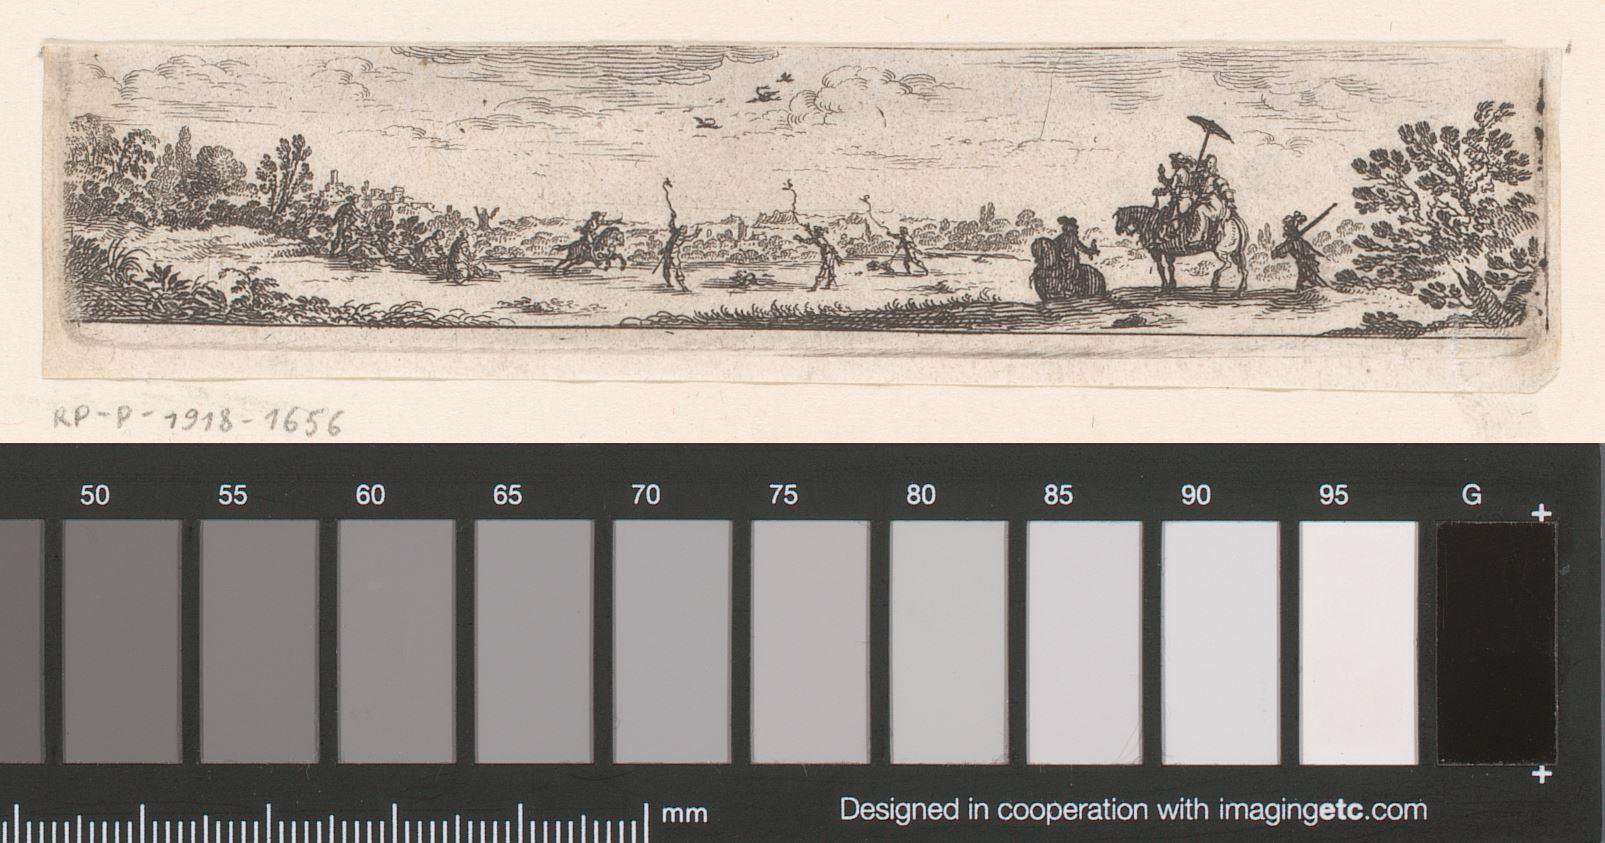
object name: print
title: Vignetten met buitentaferelen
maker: nicolas cochin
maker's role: print maker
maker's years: 1610-1686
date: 1620-1686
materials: paper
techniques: etching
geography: france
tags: riding a horse, ass, or mule; rider, horseman, landscapes, parasol, sunshade